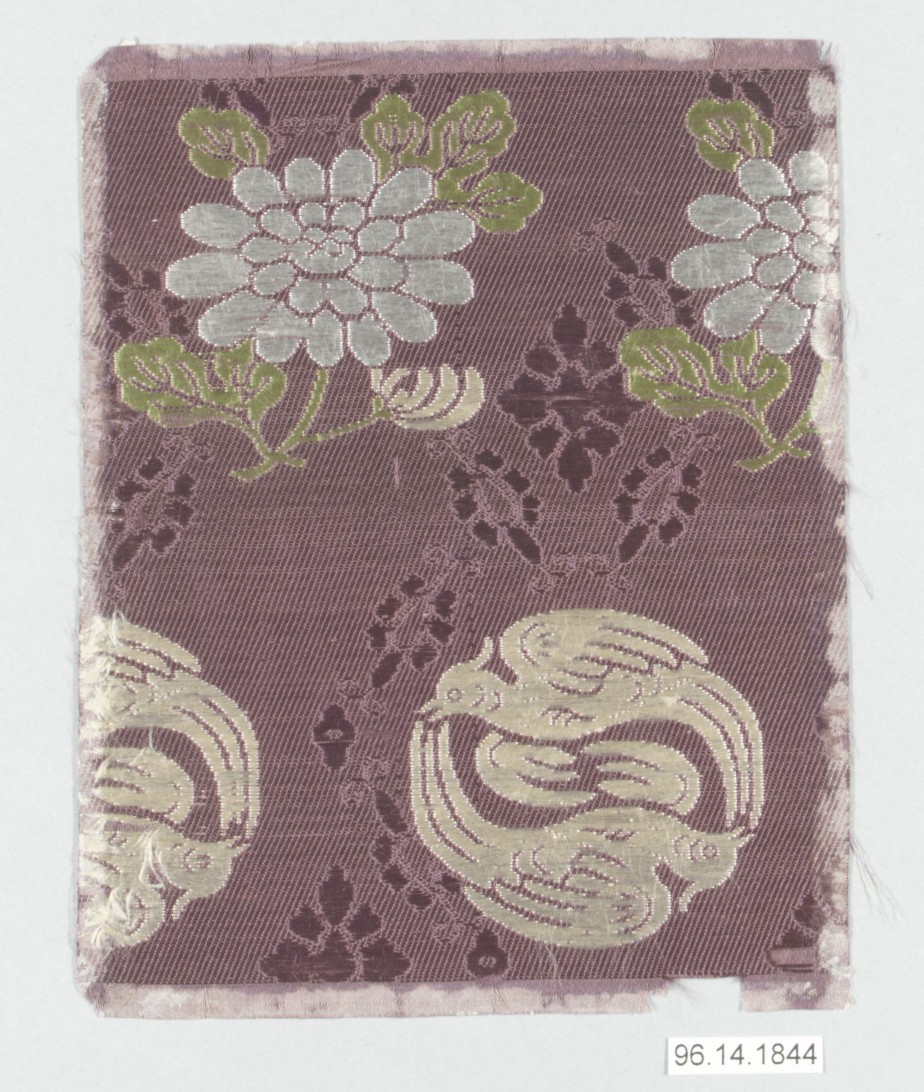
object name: piece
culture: japanese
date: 1701-1800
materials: silk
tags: birds